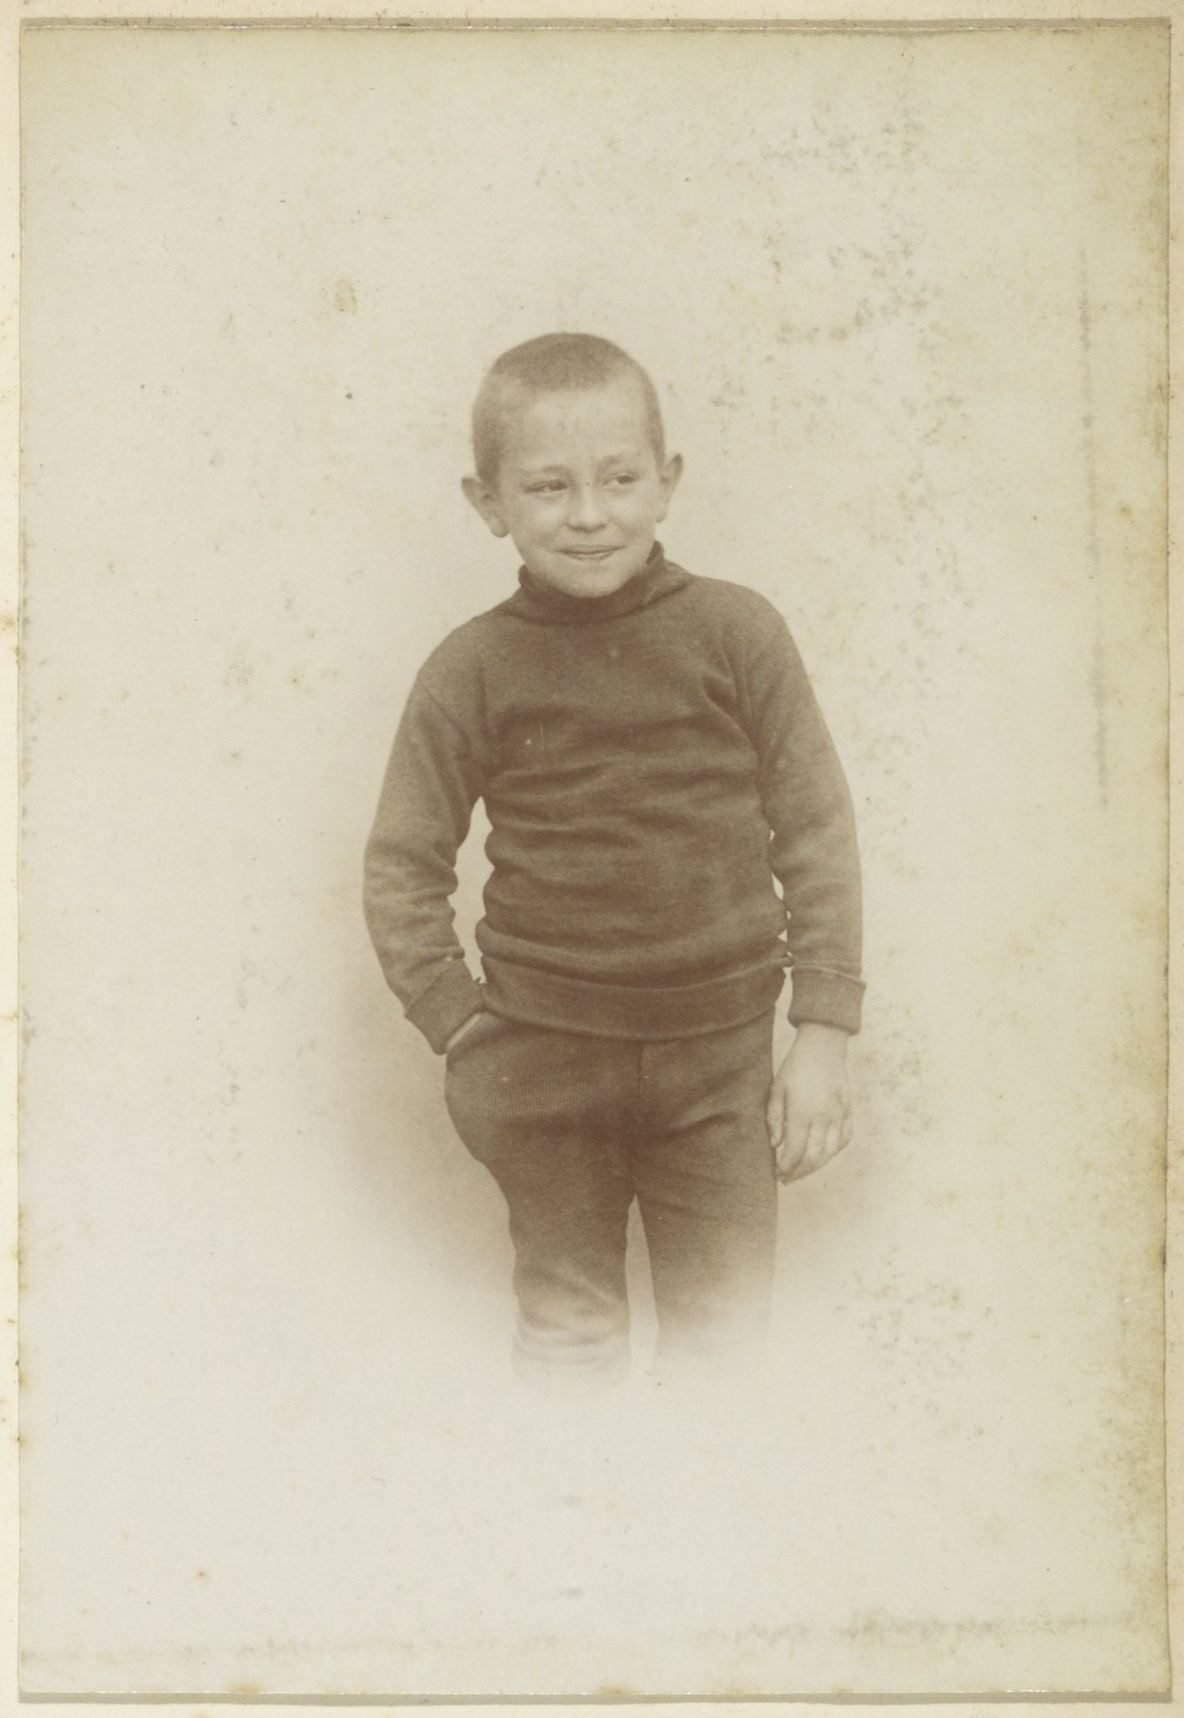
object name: photograph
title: Portret van een Franse jongen, een hand in de zak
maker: Anonymous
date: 1900-1910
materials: paper, photographic support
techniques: albumen print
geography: france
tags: hand in the pocket, child, france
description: Onderdeel van Fotoalbum van een Franse amateurfotograaf met opnames van een familie, distilleerderij Delizy & Doistau Fils, het leger en bezienswaardigheden in Frankrijk.